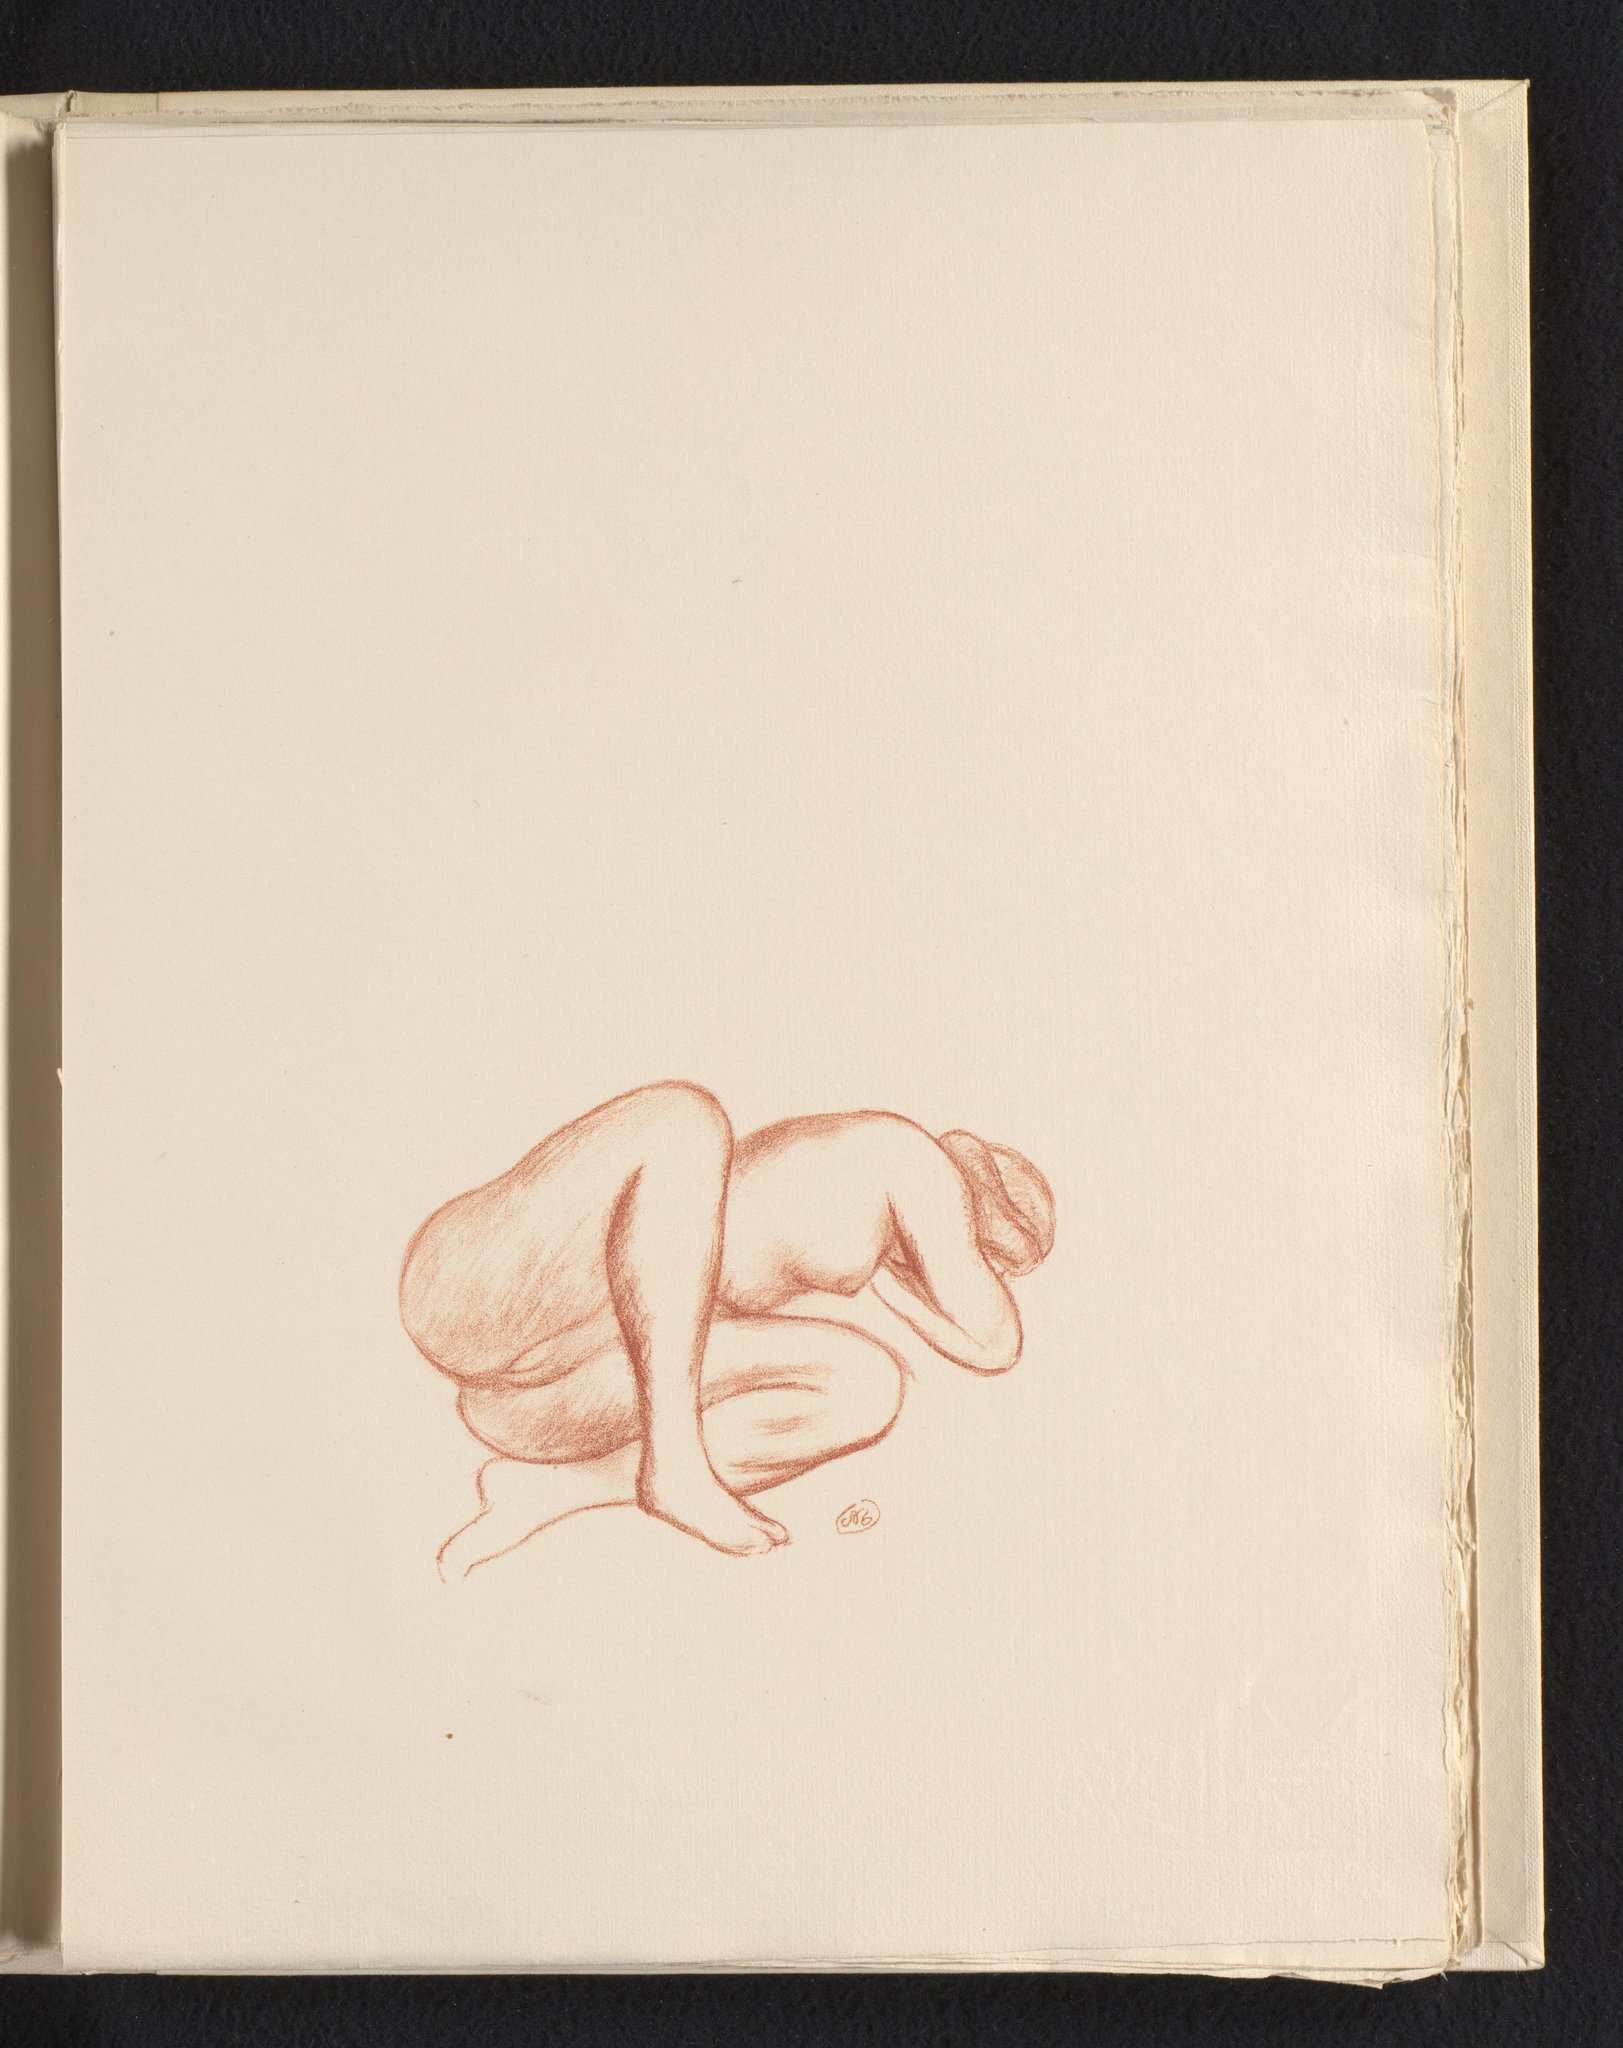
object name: book illustration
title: Knielende naakte vrouw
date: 1948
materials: paper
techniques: lithograph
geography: paris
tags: kneeling figure - aa - female human figure, woman (showing herself) undressed, quasi-nude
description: Prent uit: Lucianus van Samosata. Dialogues des Courtisanes. [Vertaald uit het Grieks door] Charles Astruc. Parijs: s.n., 1948, deel van de suite met een extra afdruk van de prenten in sanguine.